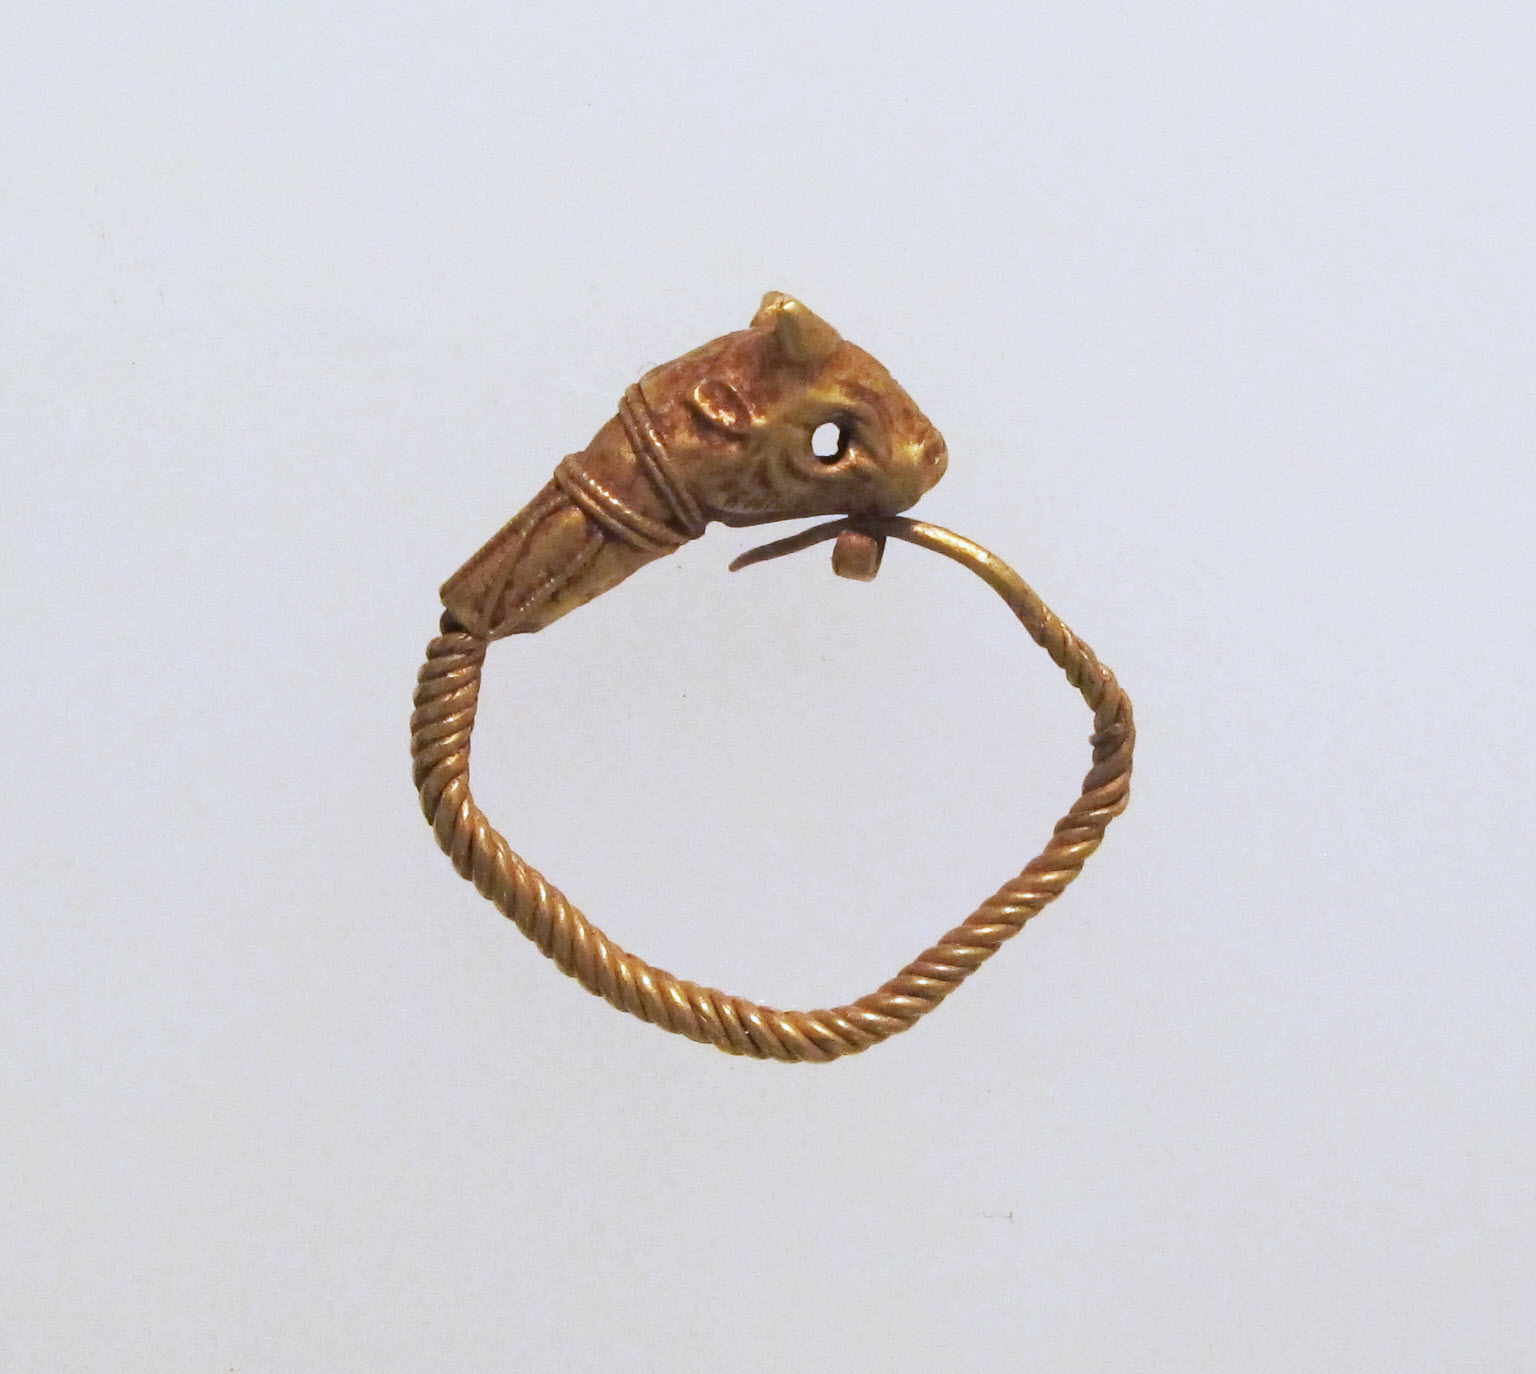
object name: earring with head of bull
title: Gold earring with head of a bull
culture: greek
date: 400-201 BCE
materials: gold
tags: bulls